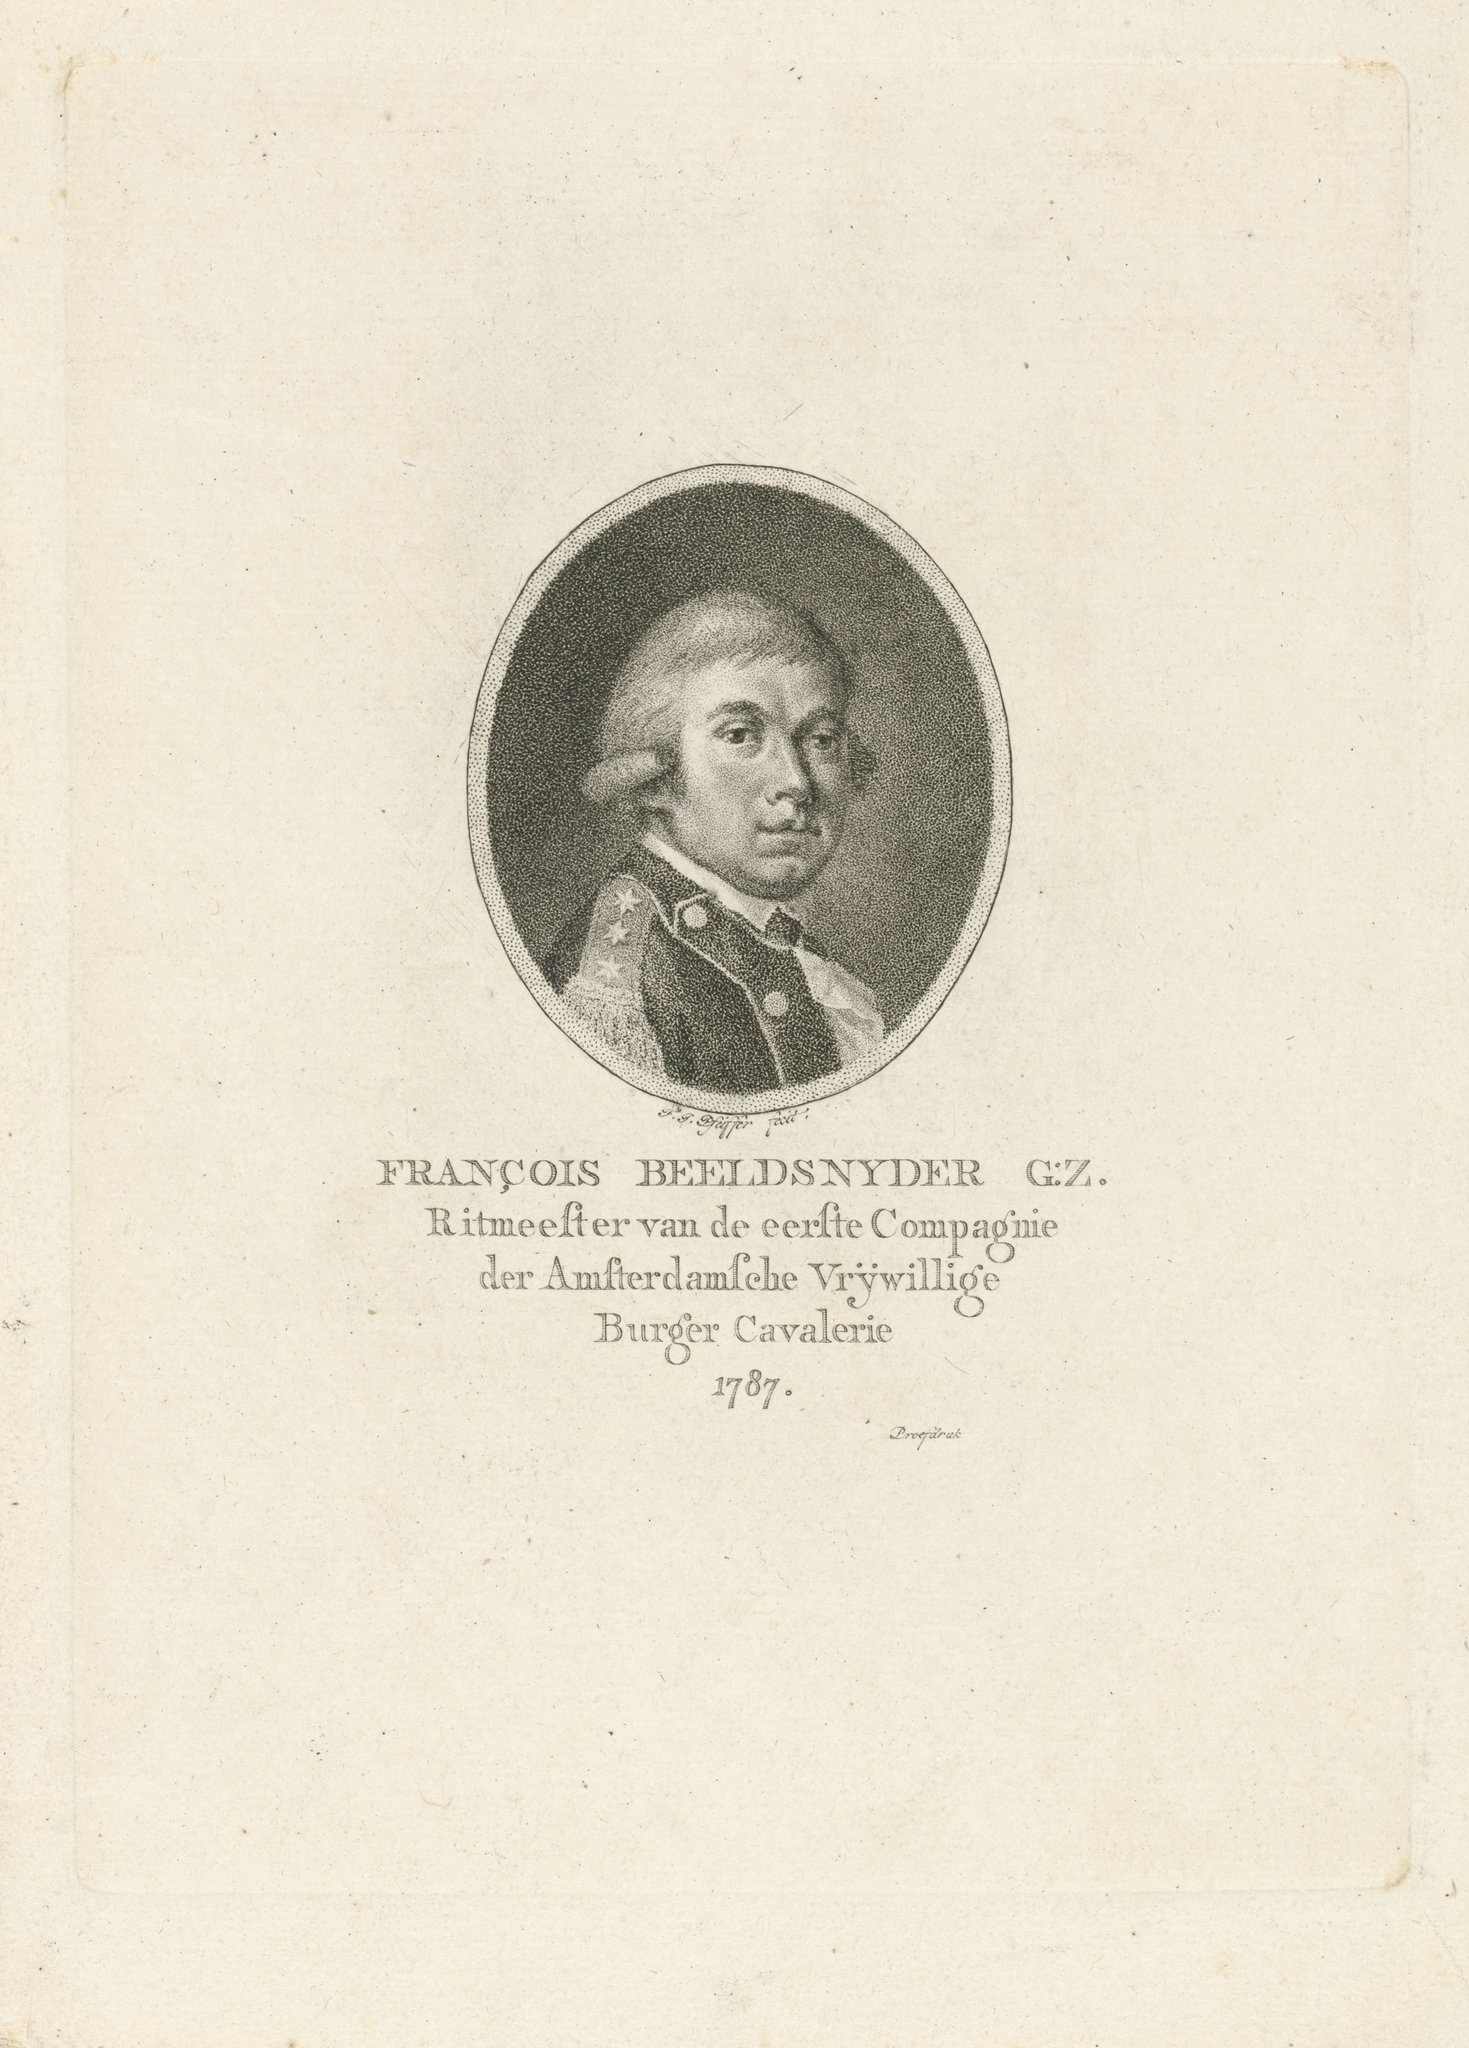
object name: print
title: Portret van François Beeldsnijder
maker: françois joseph pfeiffer (i)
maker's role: print maker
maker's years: 1741-1807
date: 1787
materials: paper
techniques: etching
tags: historical persons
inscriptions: collector's mark: Lugt 2228